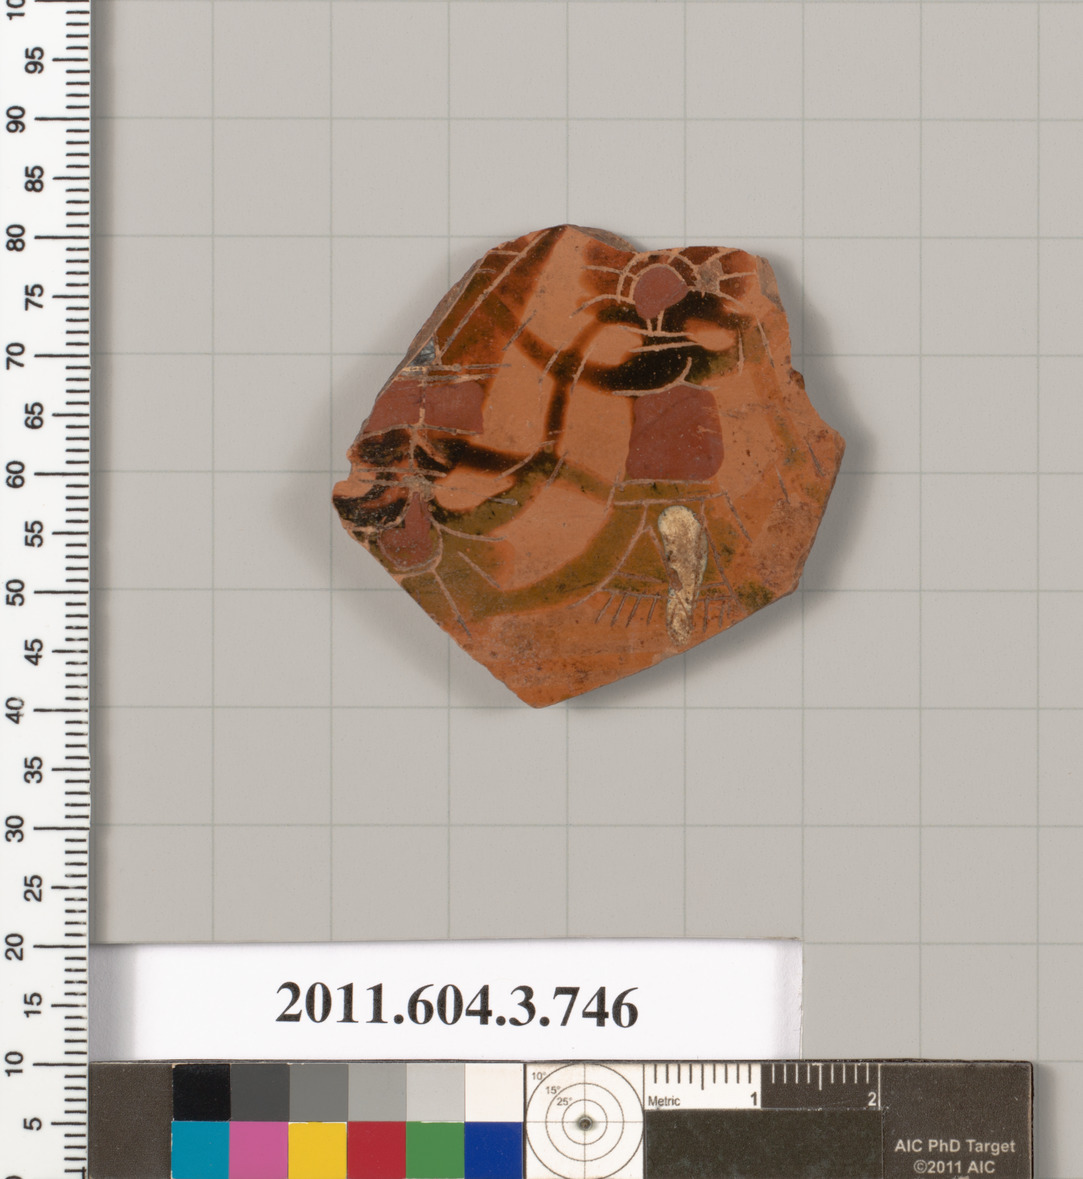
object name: neck amphora, tyrrhenian fragment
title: Terracotta fragment of a neck-amphora (jar)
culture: greek, attic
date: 575-551 BCE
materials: terracotta